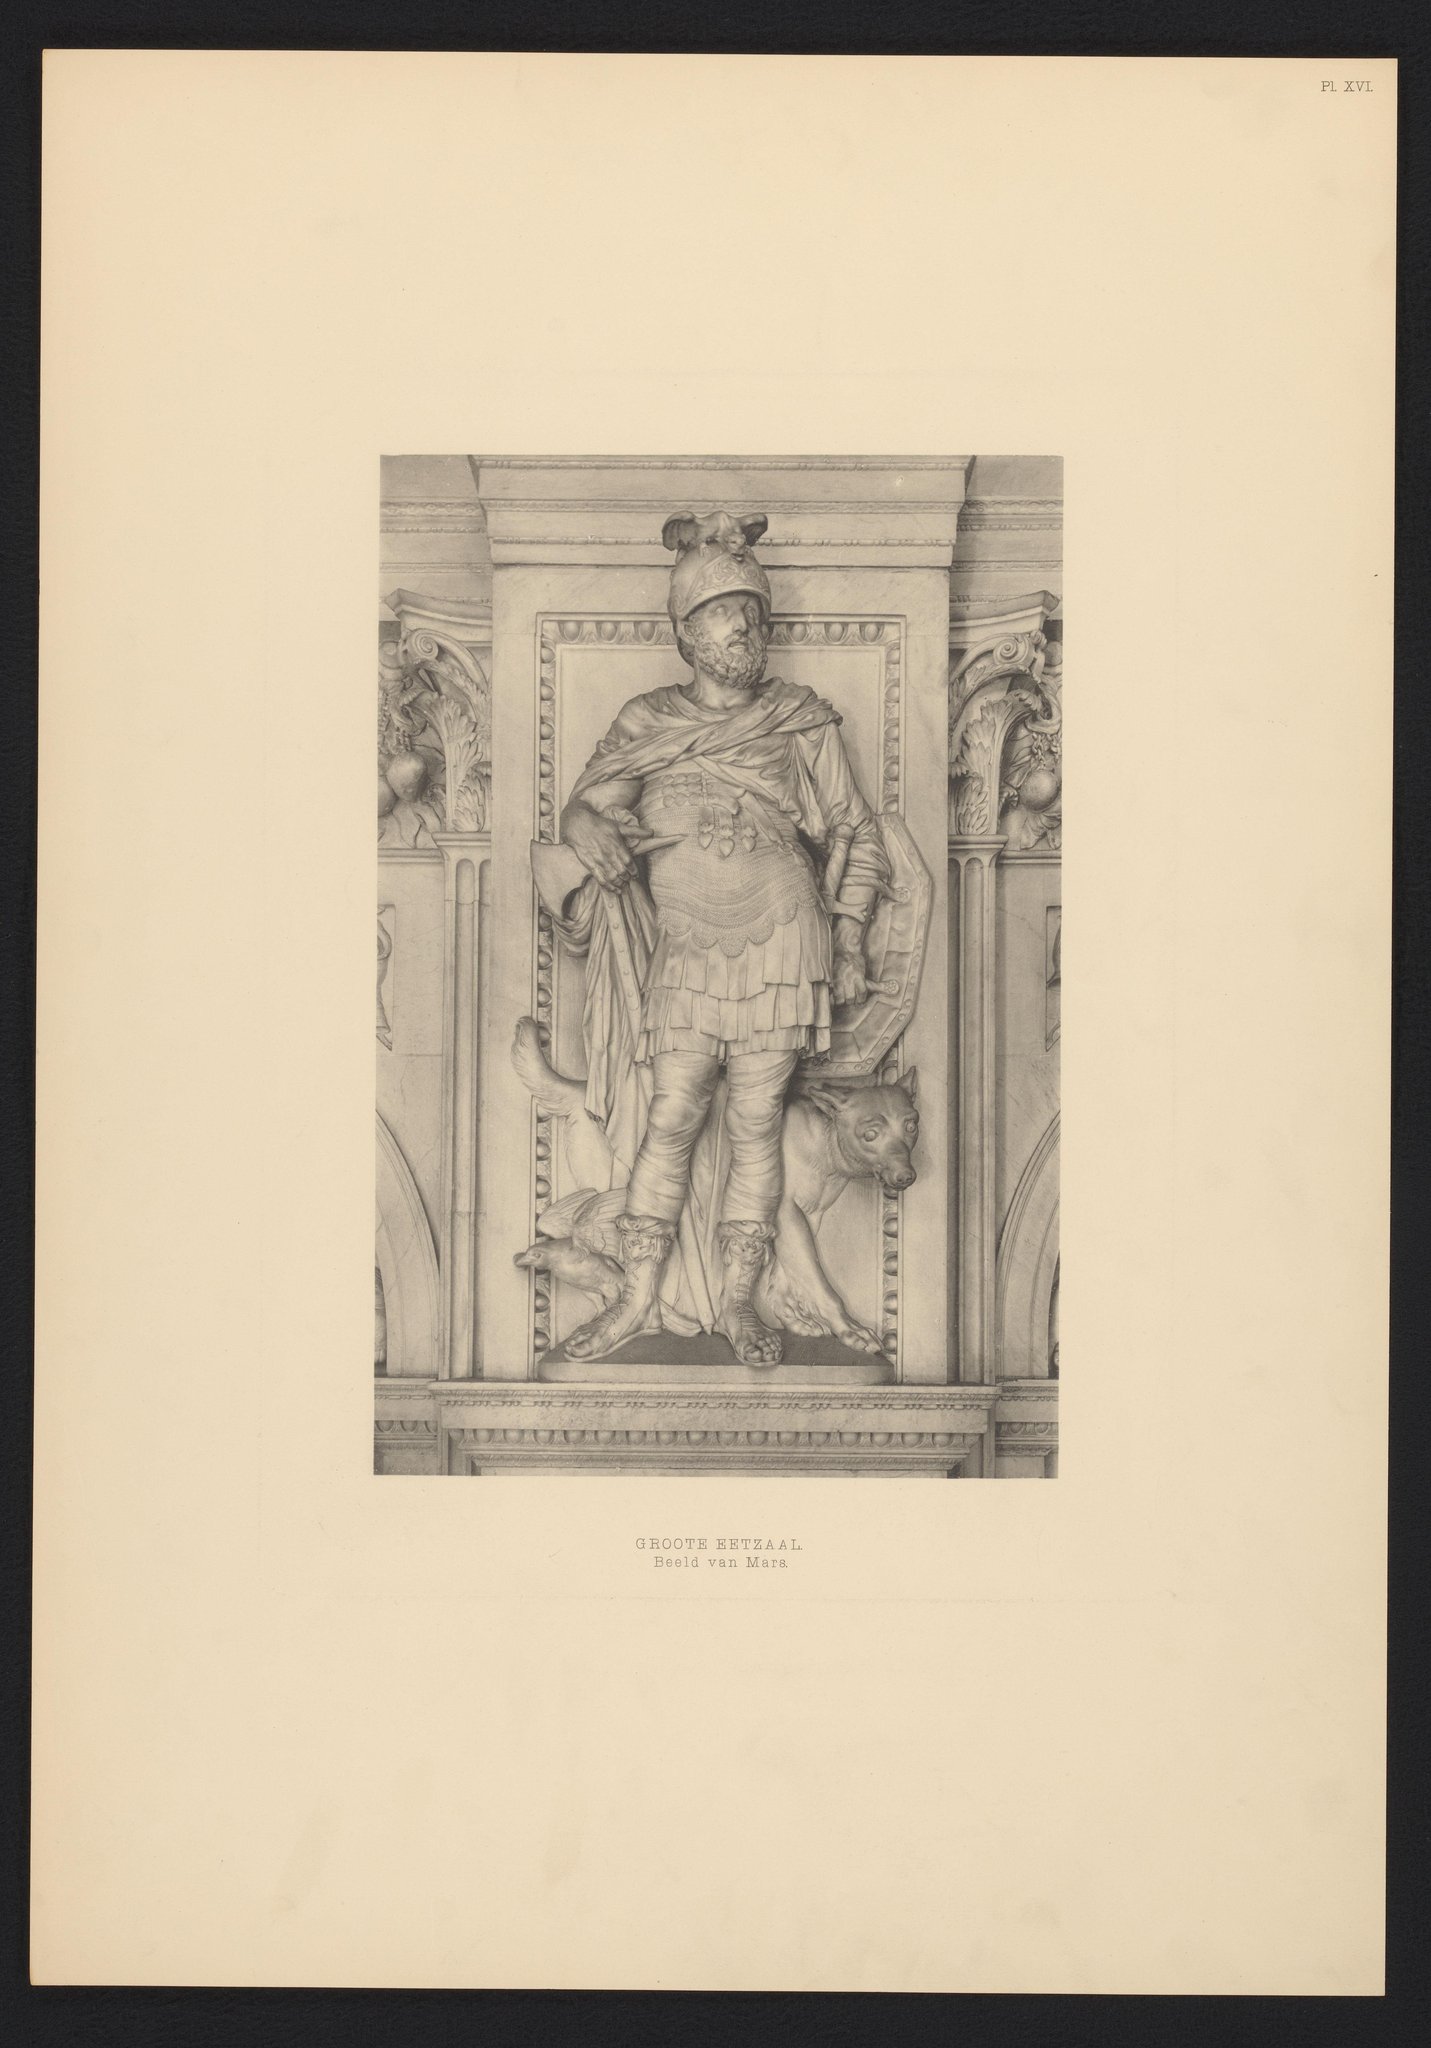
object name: photograph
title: C.T.J. Louis Rieber, Het Koninklijk Paleis te Amsterdam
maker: Anonymous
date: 1899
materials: cardboard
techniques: photograph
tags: palace, piece of sculpture, reproduction of a piece of sculpture, royal palace of amsterdam